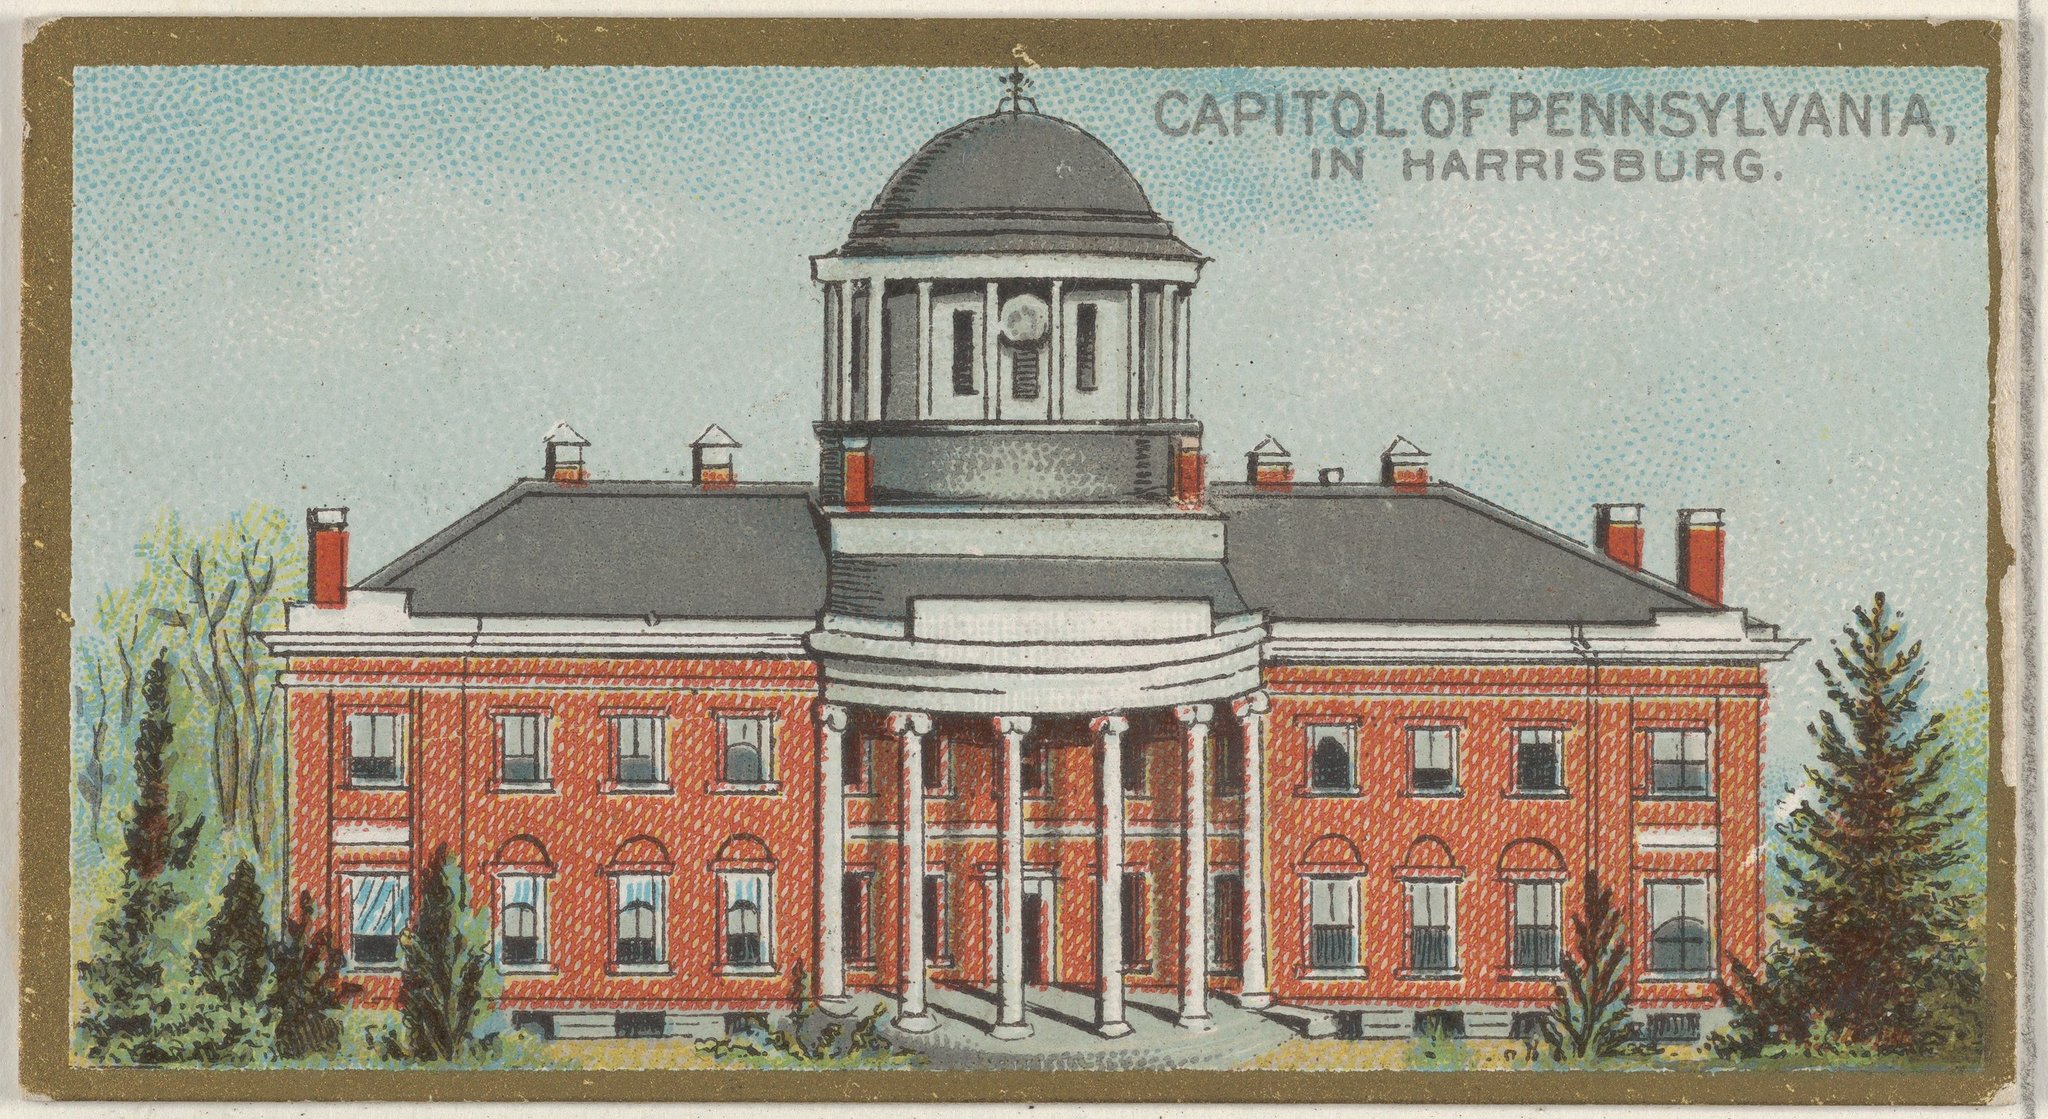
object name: print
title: Capitol of Pennsylvania in Harrisburg, from the General Government and State Capitol Buildings series (N14) for Allen & Ginter Cigarettes Brands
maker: allen & ginter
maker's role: publisher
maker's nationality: american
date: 1889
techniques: color lithograph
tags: buildings